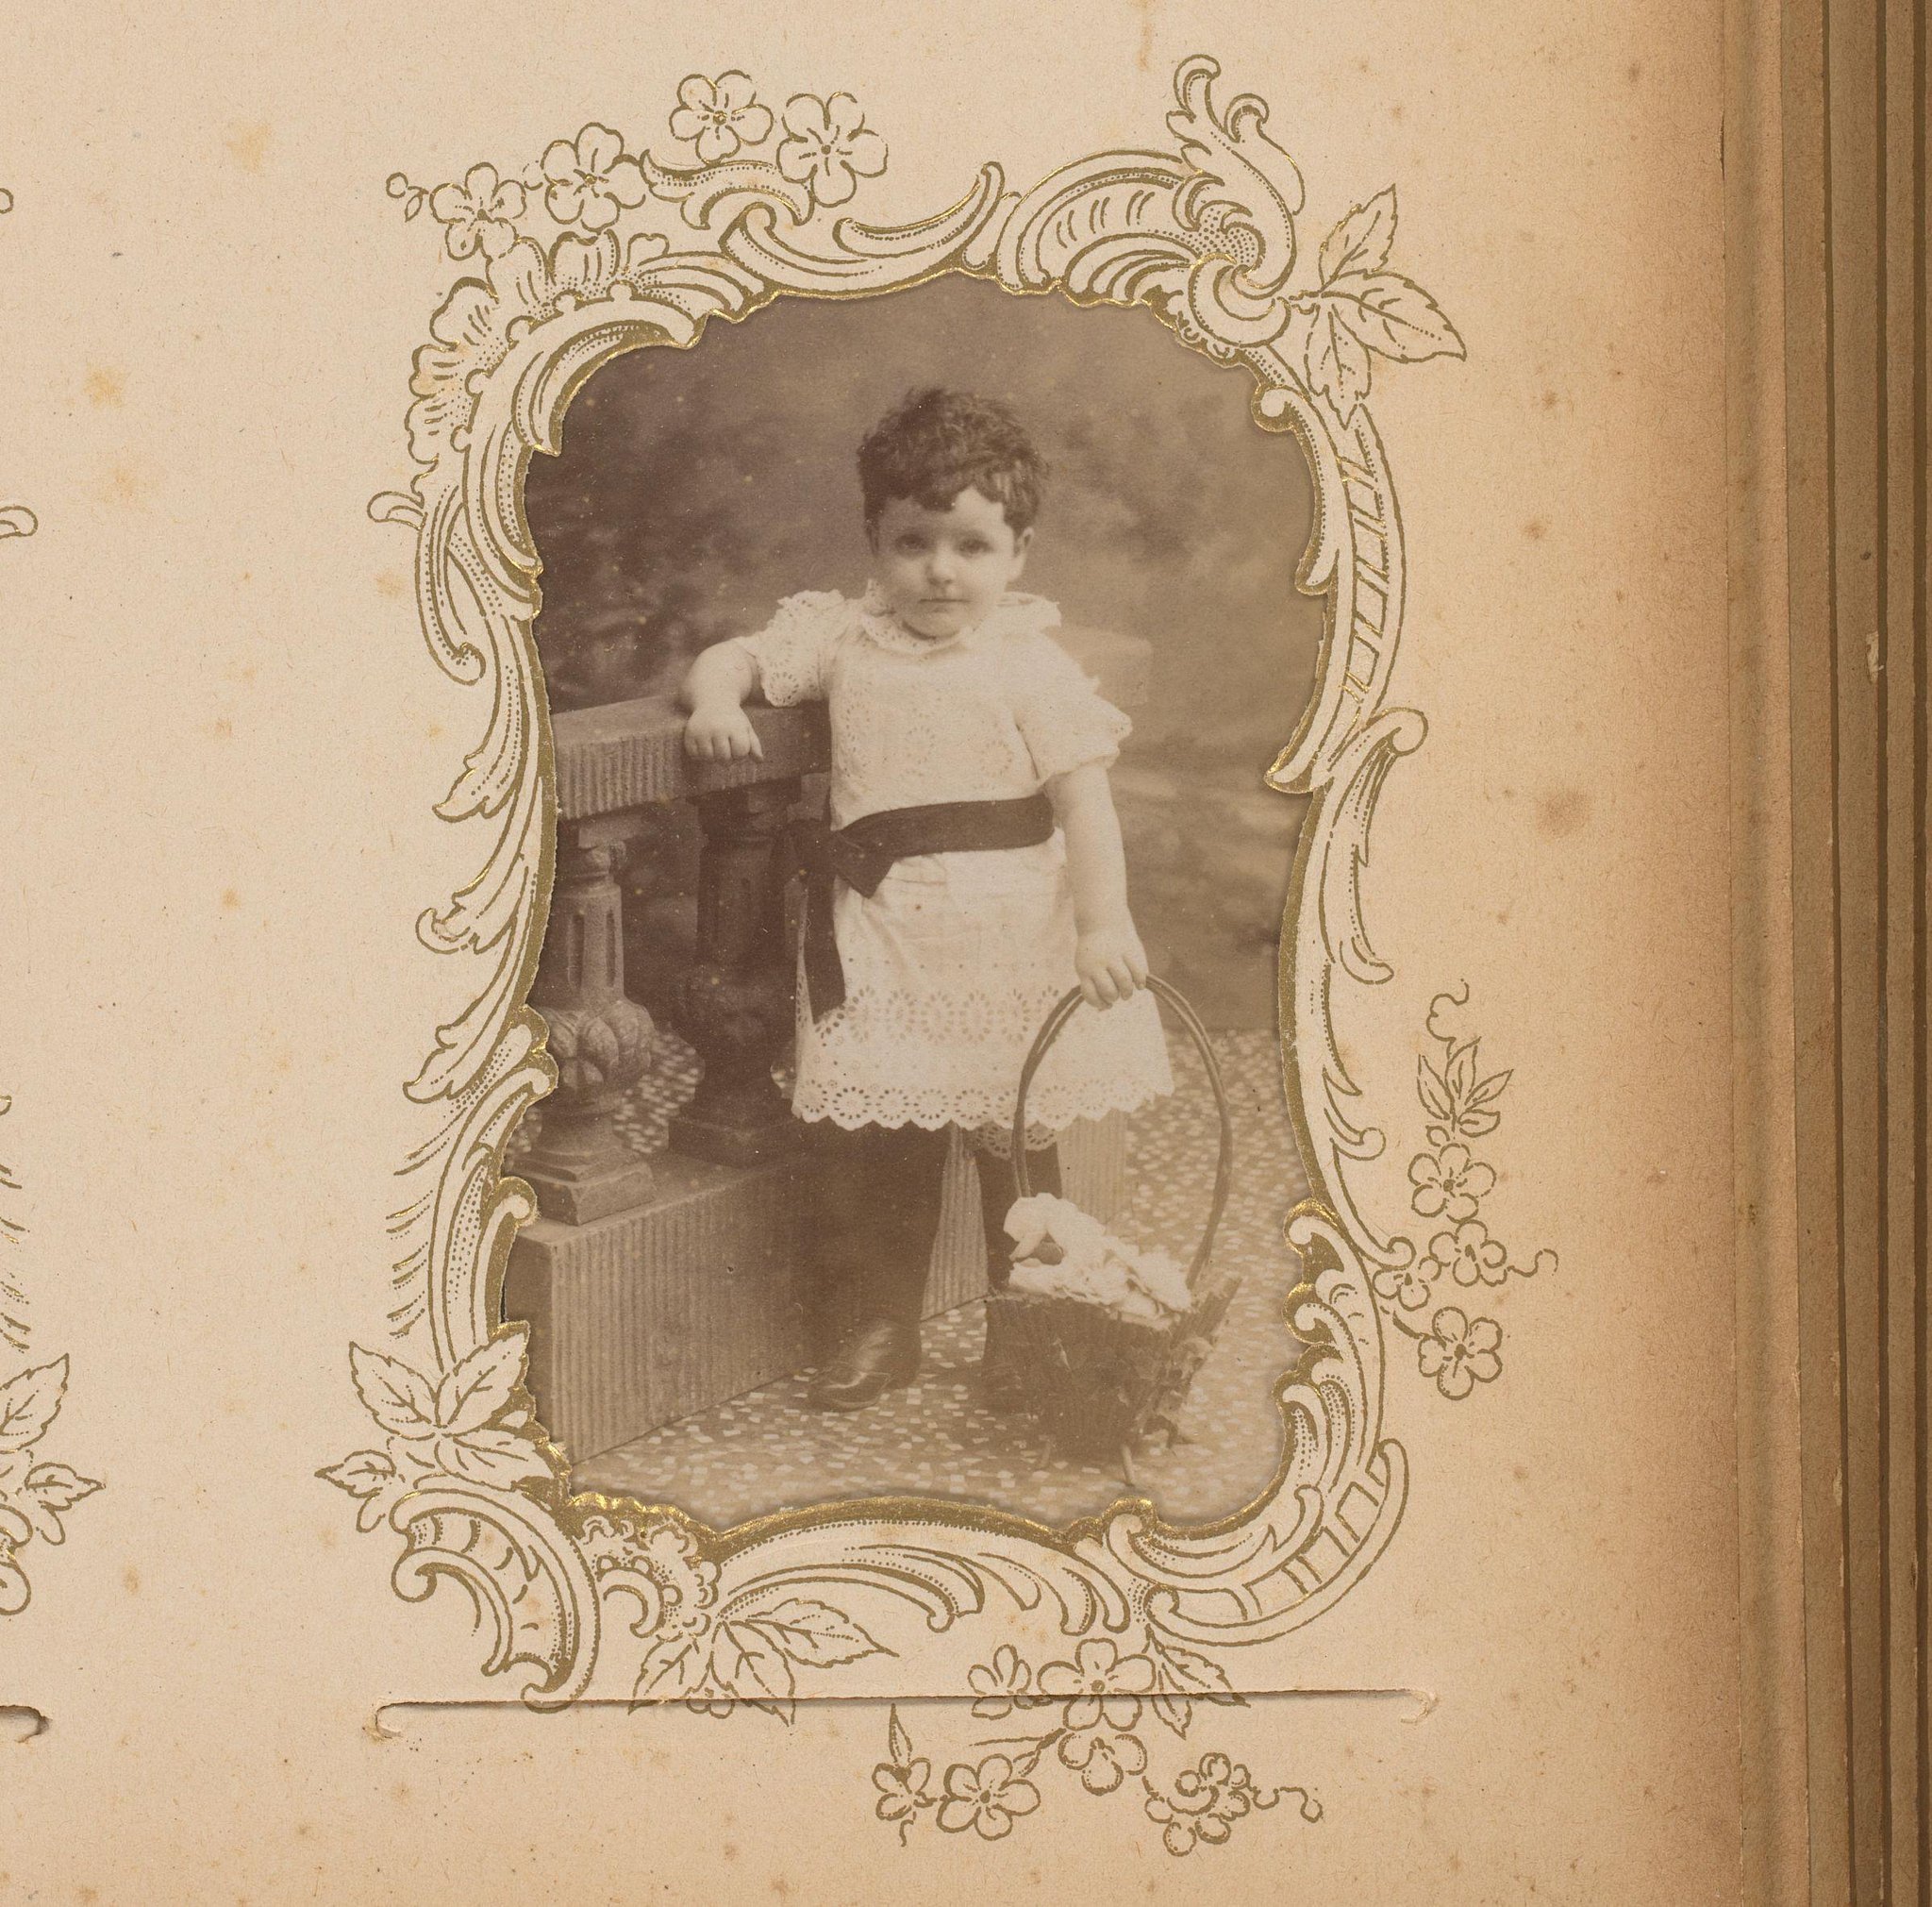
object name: carte de visite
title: Portret van een meisje met mand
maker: Anonymous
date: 1870-1900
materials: cardboard, photographic support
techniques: albumen print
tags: historical persons - bb - woman, container made of plant material other than wood: basket, girl (child between toddler and youth)